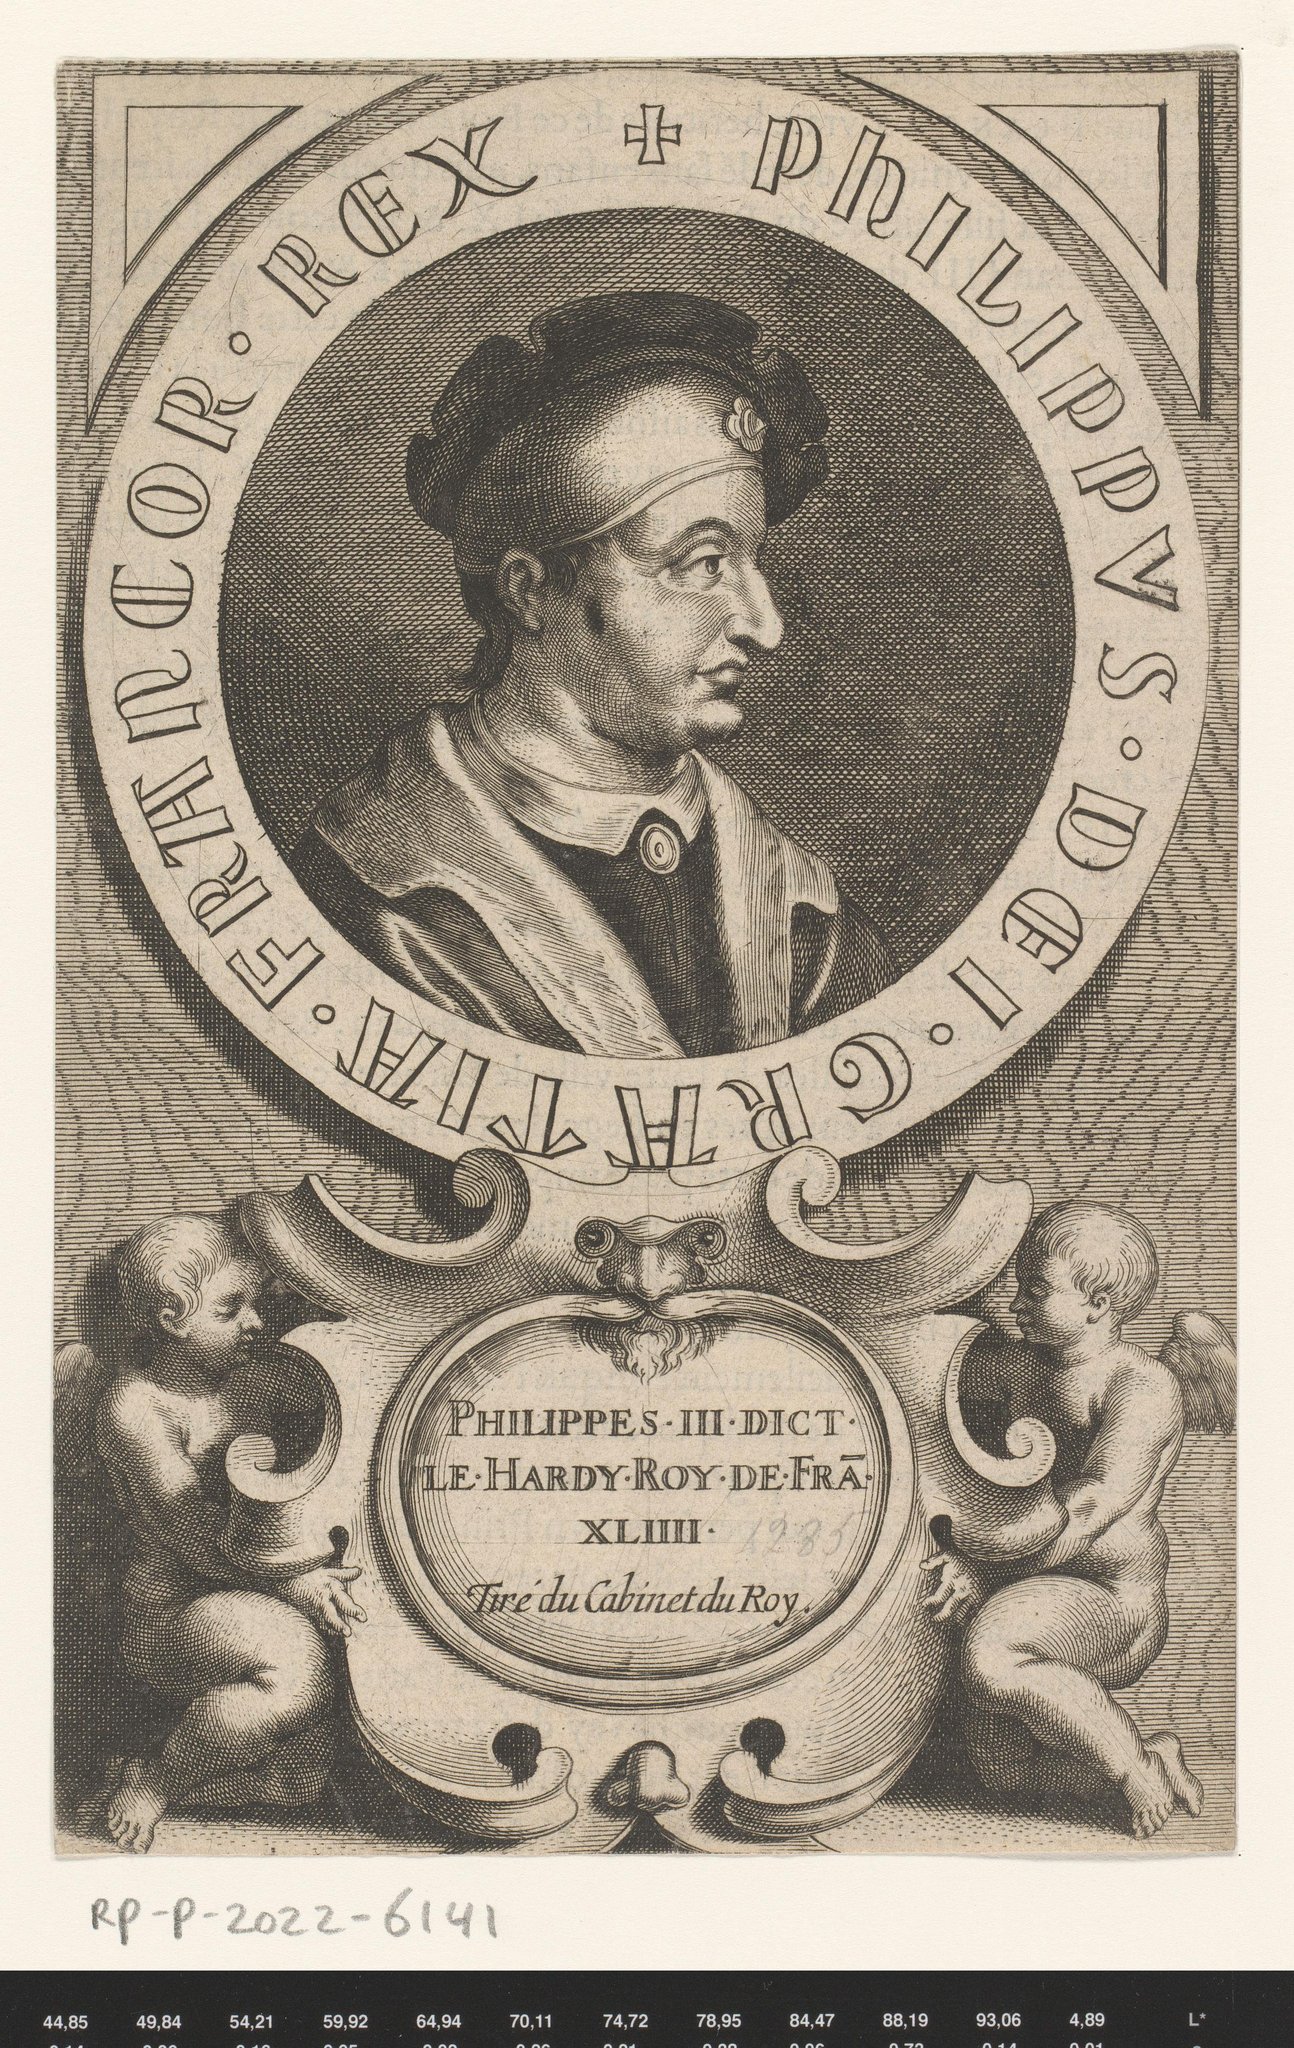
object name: book illustration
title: Portret van Filips III van Frankrijk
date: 1636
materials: paper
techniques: engraving, letterpress printing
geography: paris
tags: historical persons, king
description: Prent uit: Bie, Jacob de. Les vrais portraits des rois de France. (...) Parijs: Jean Camusat, 1636, dl. 2, p. 249.